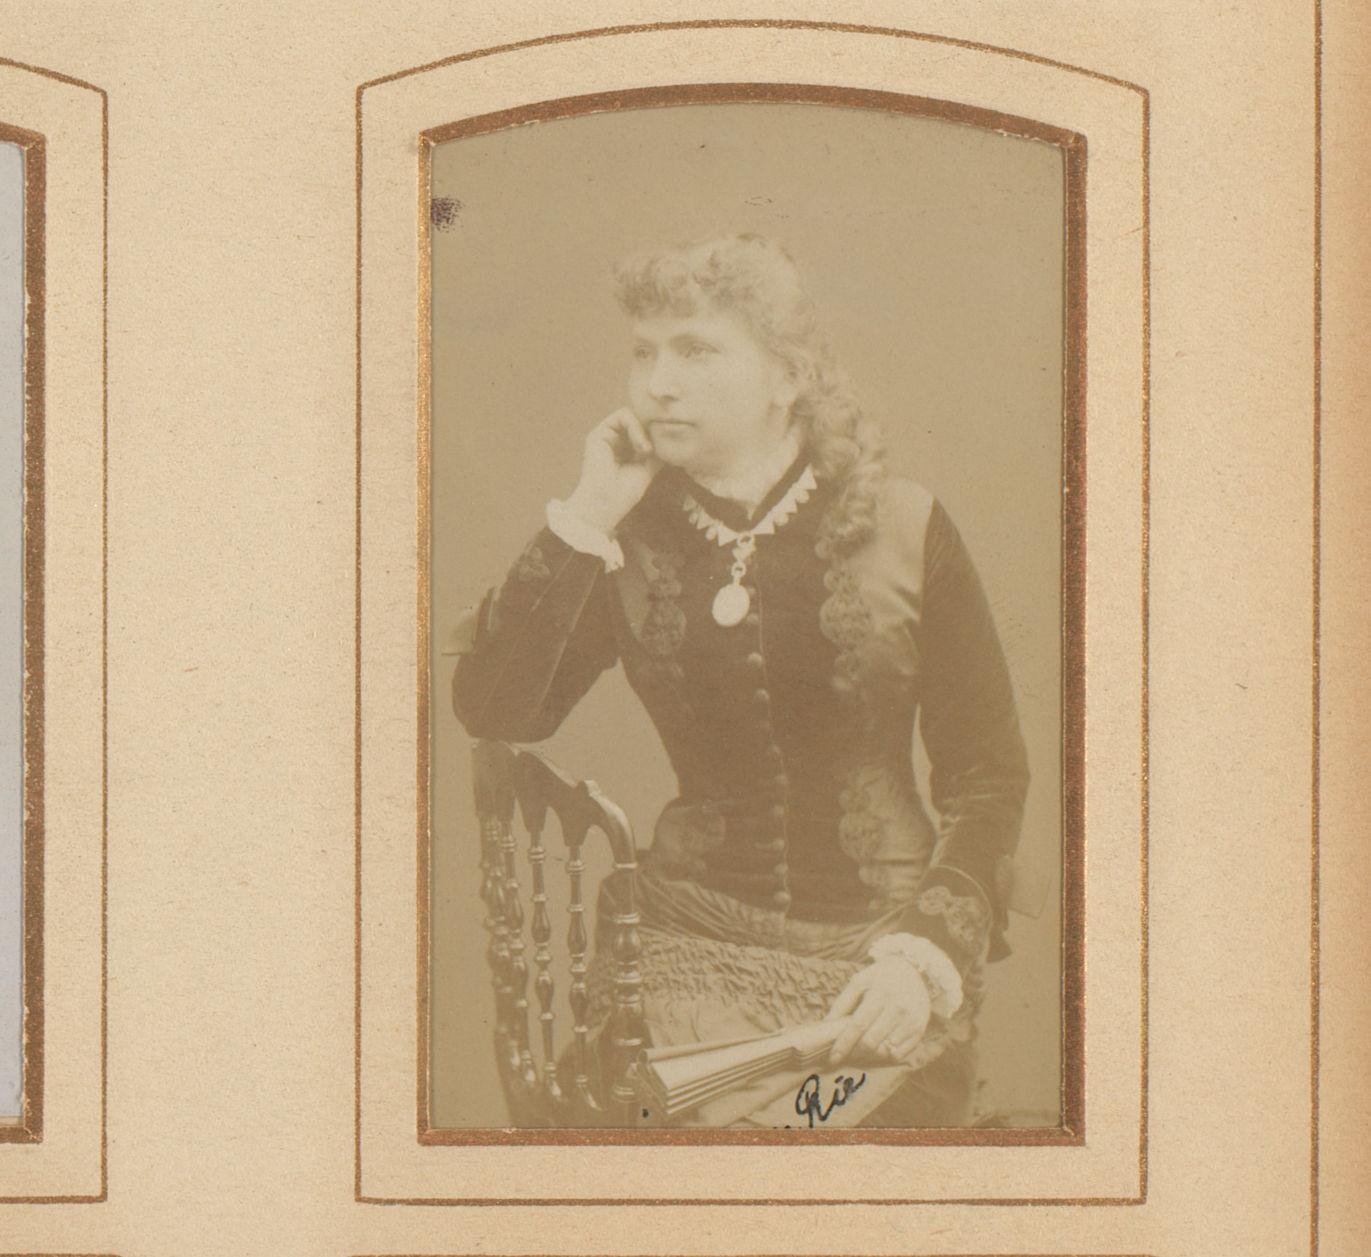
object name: album leaf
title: Portret van een jonge vrouw, aangeduid als tante Ria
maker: adolphe zimmermans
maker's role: fotograaf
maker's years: 1858-1922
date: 1880-1900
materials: cardboard, photographic support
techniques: albumen print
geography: the hague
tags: adolescent, young woman, maiden, historical persons - bb - woman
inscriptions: annotation: ‘tante Ria’, inscription: ‘Adolphe/ Riemerstraat No.48/ La Haye’